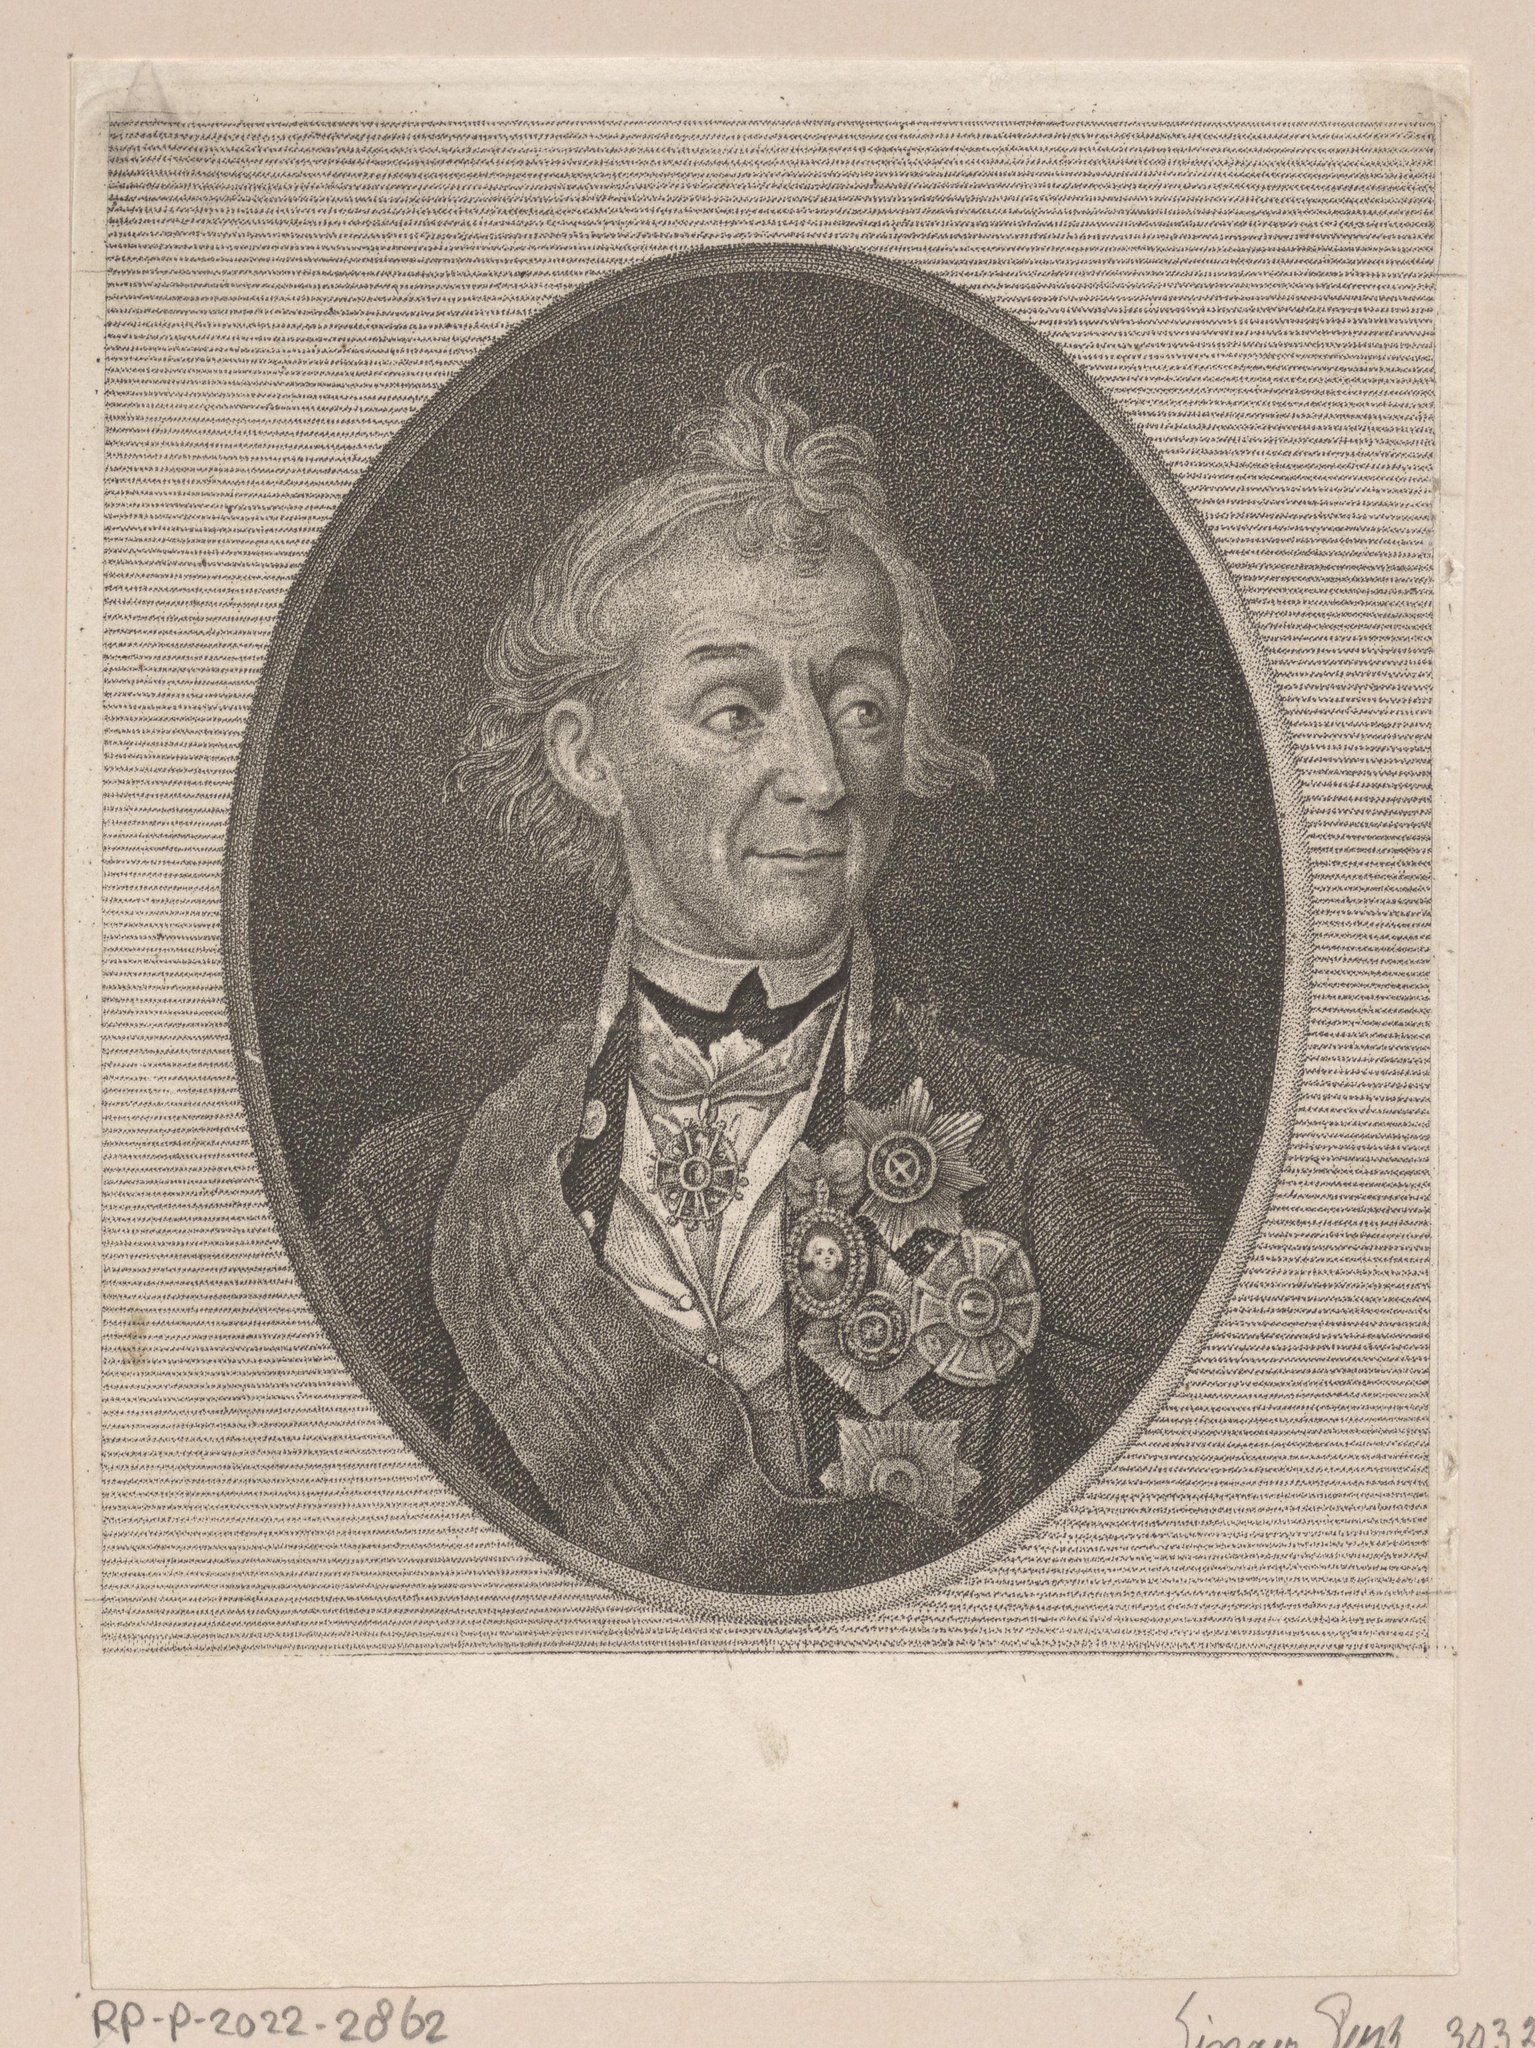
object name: print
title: Portret van Aleksandr Soevorov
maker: Anonymous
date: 1762-1850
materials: paper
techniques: etching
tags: commander-in-chief, general, marshal, historical persons